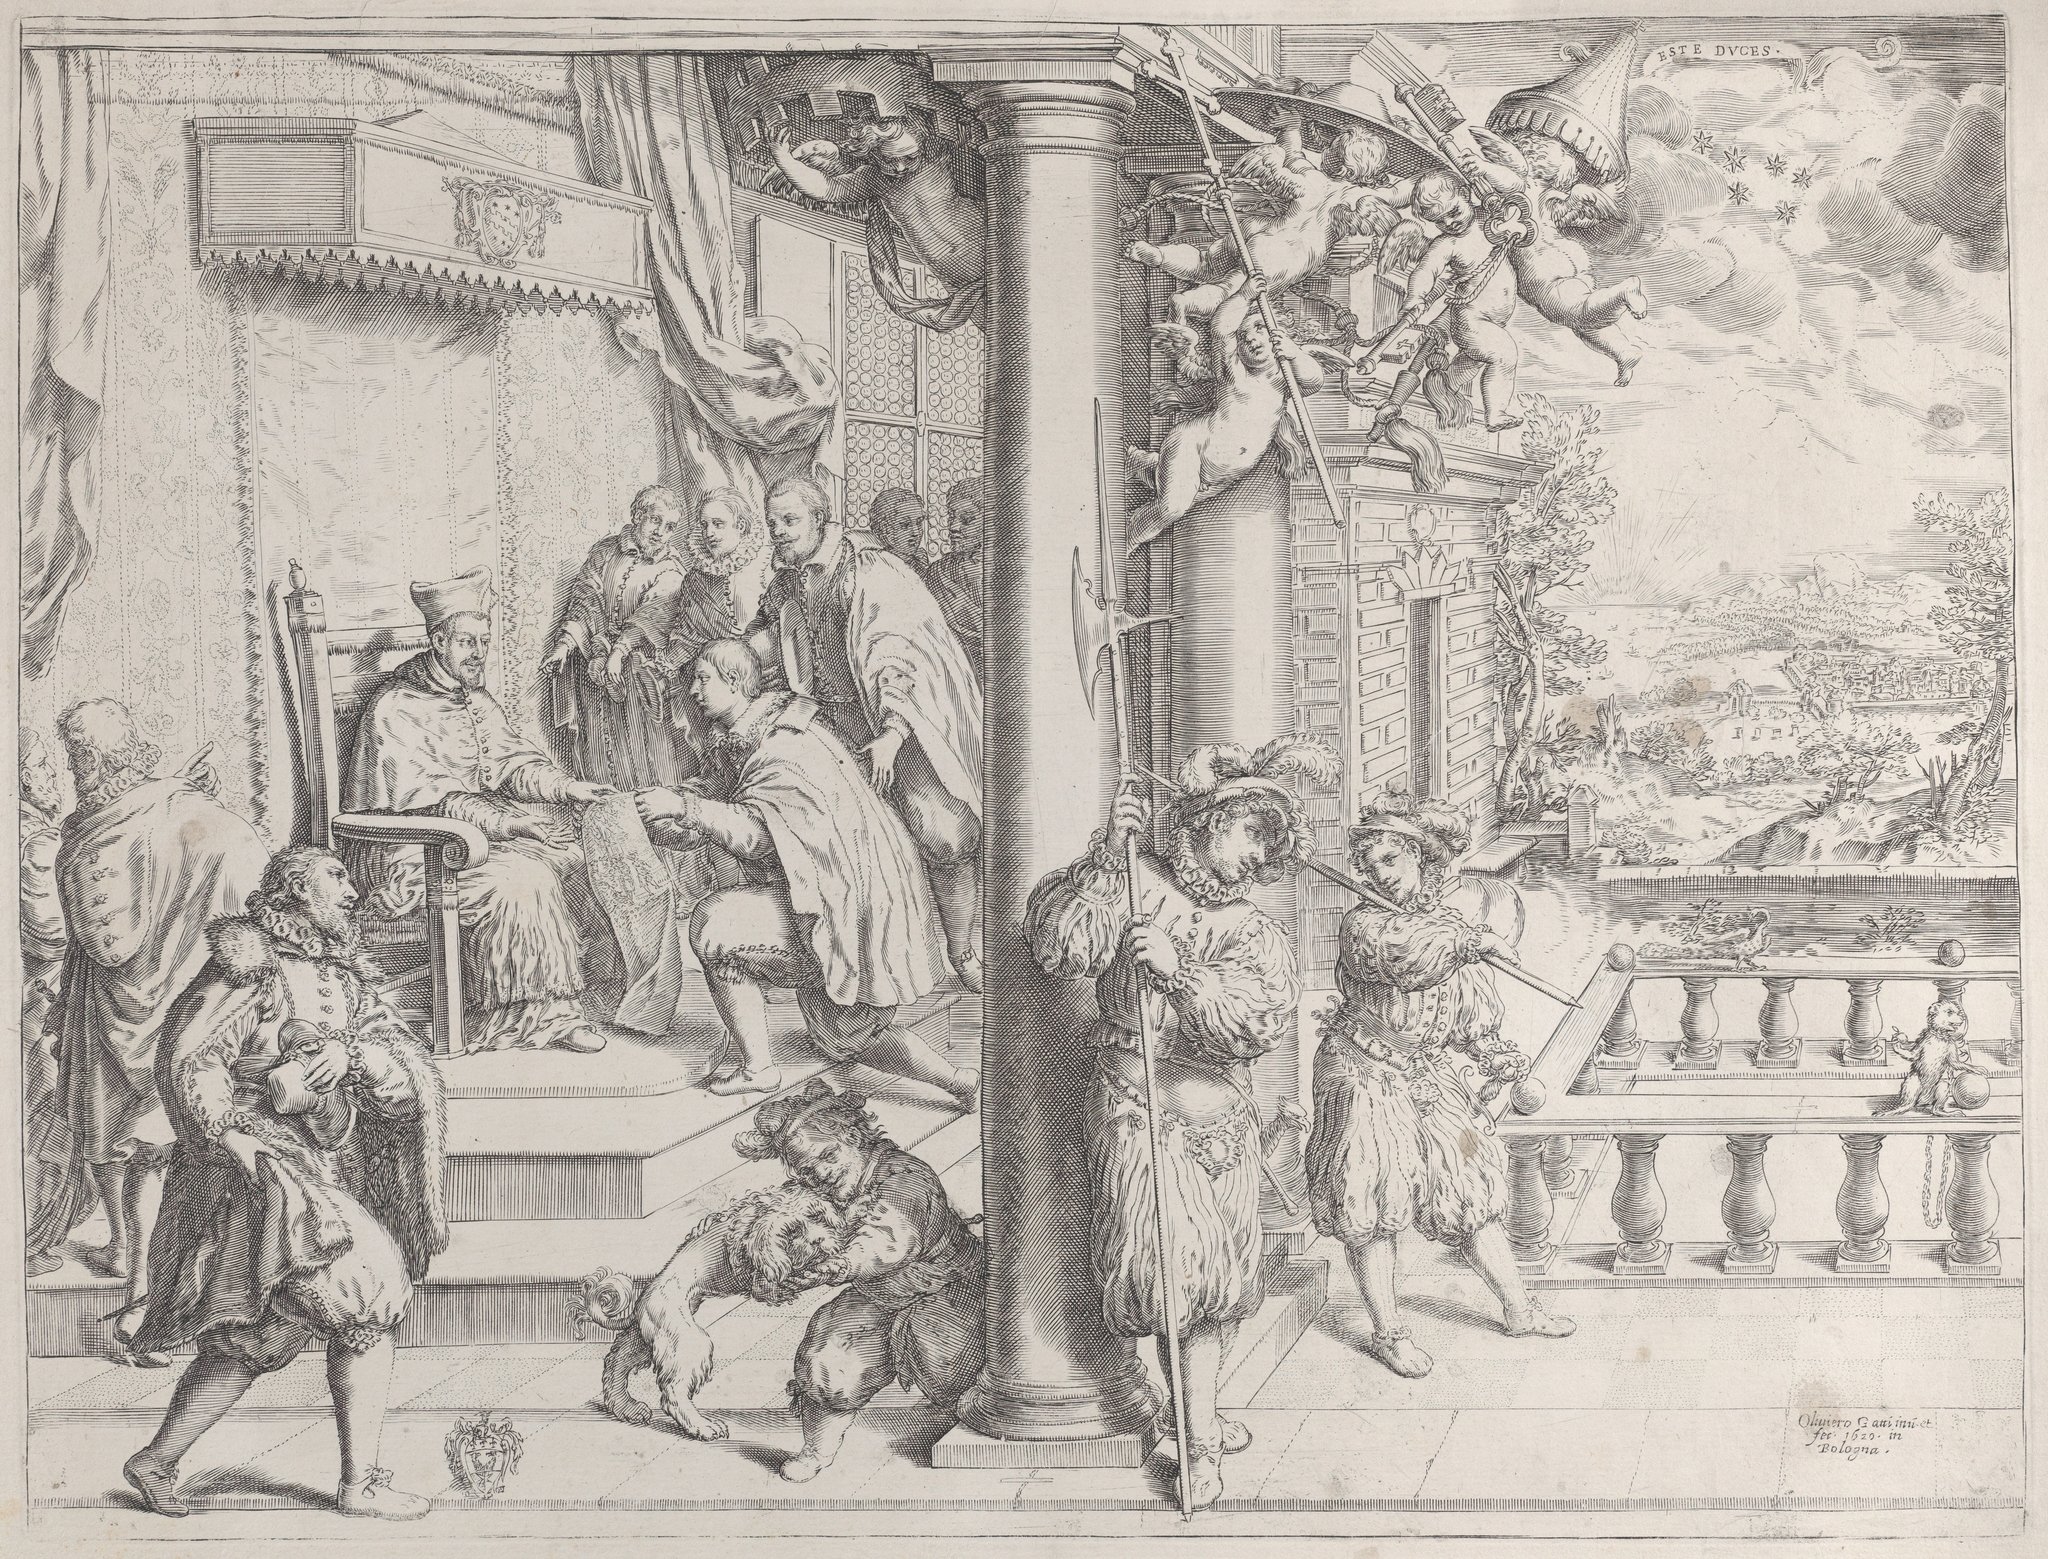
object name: print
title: A Young Man Presenting his Thesis to Cardinal Aldobrandini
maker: oliviero gatti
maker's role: artist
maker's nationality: italian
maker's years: 1610-1630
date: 1620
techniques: engraving